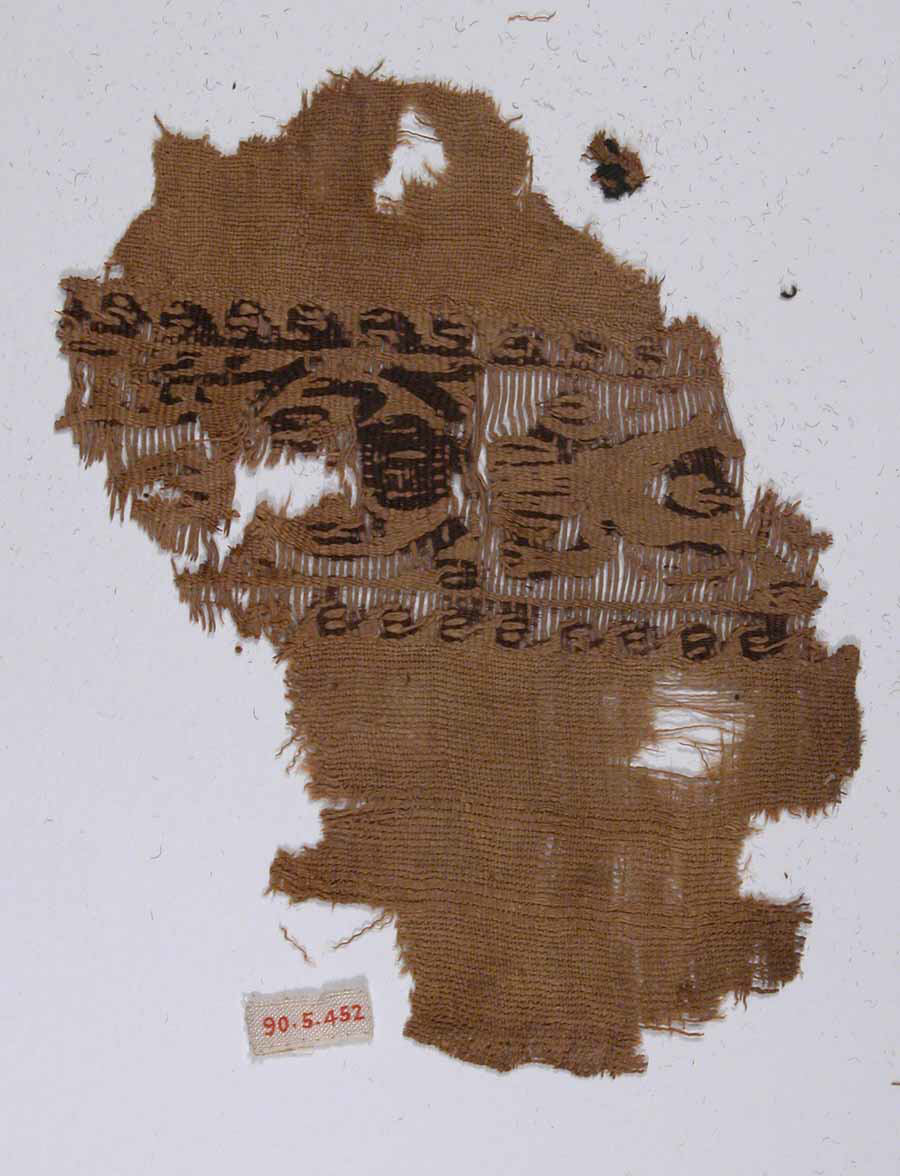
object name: textile fragment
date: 301-500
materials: linen, wool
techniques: weave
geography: egypt